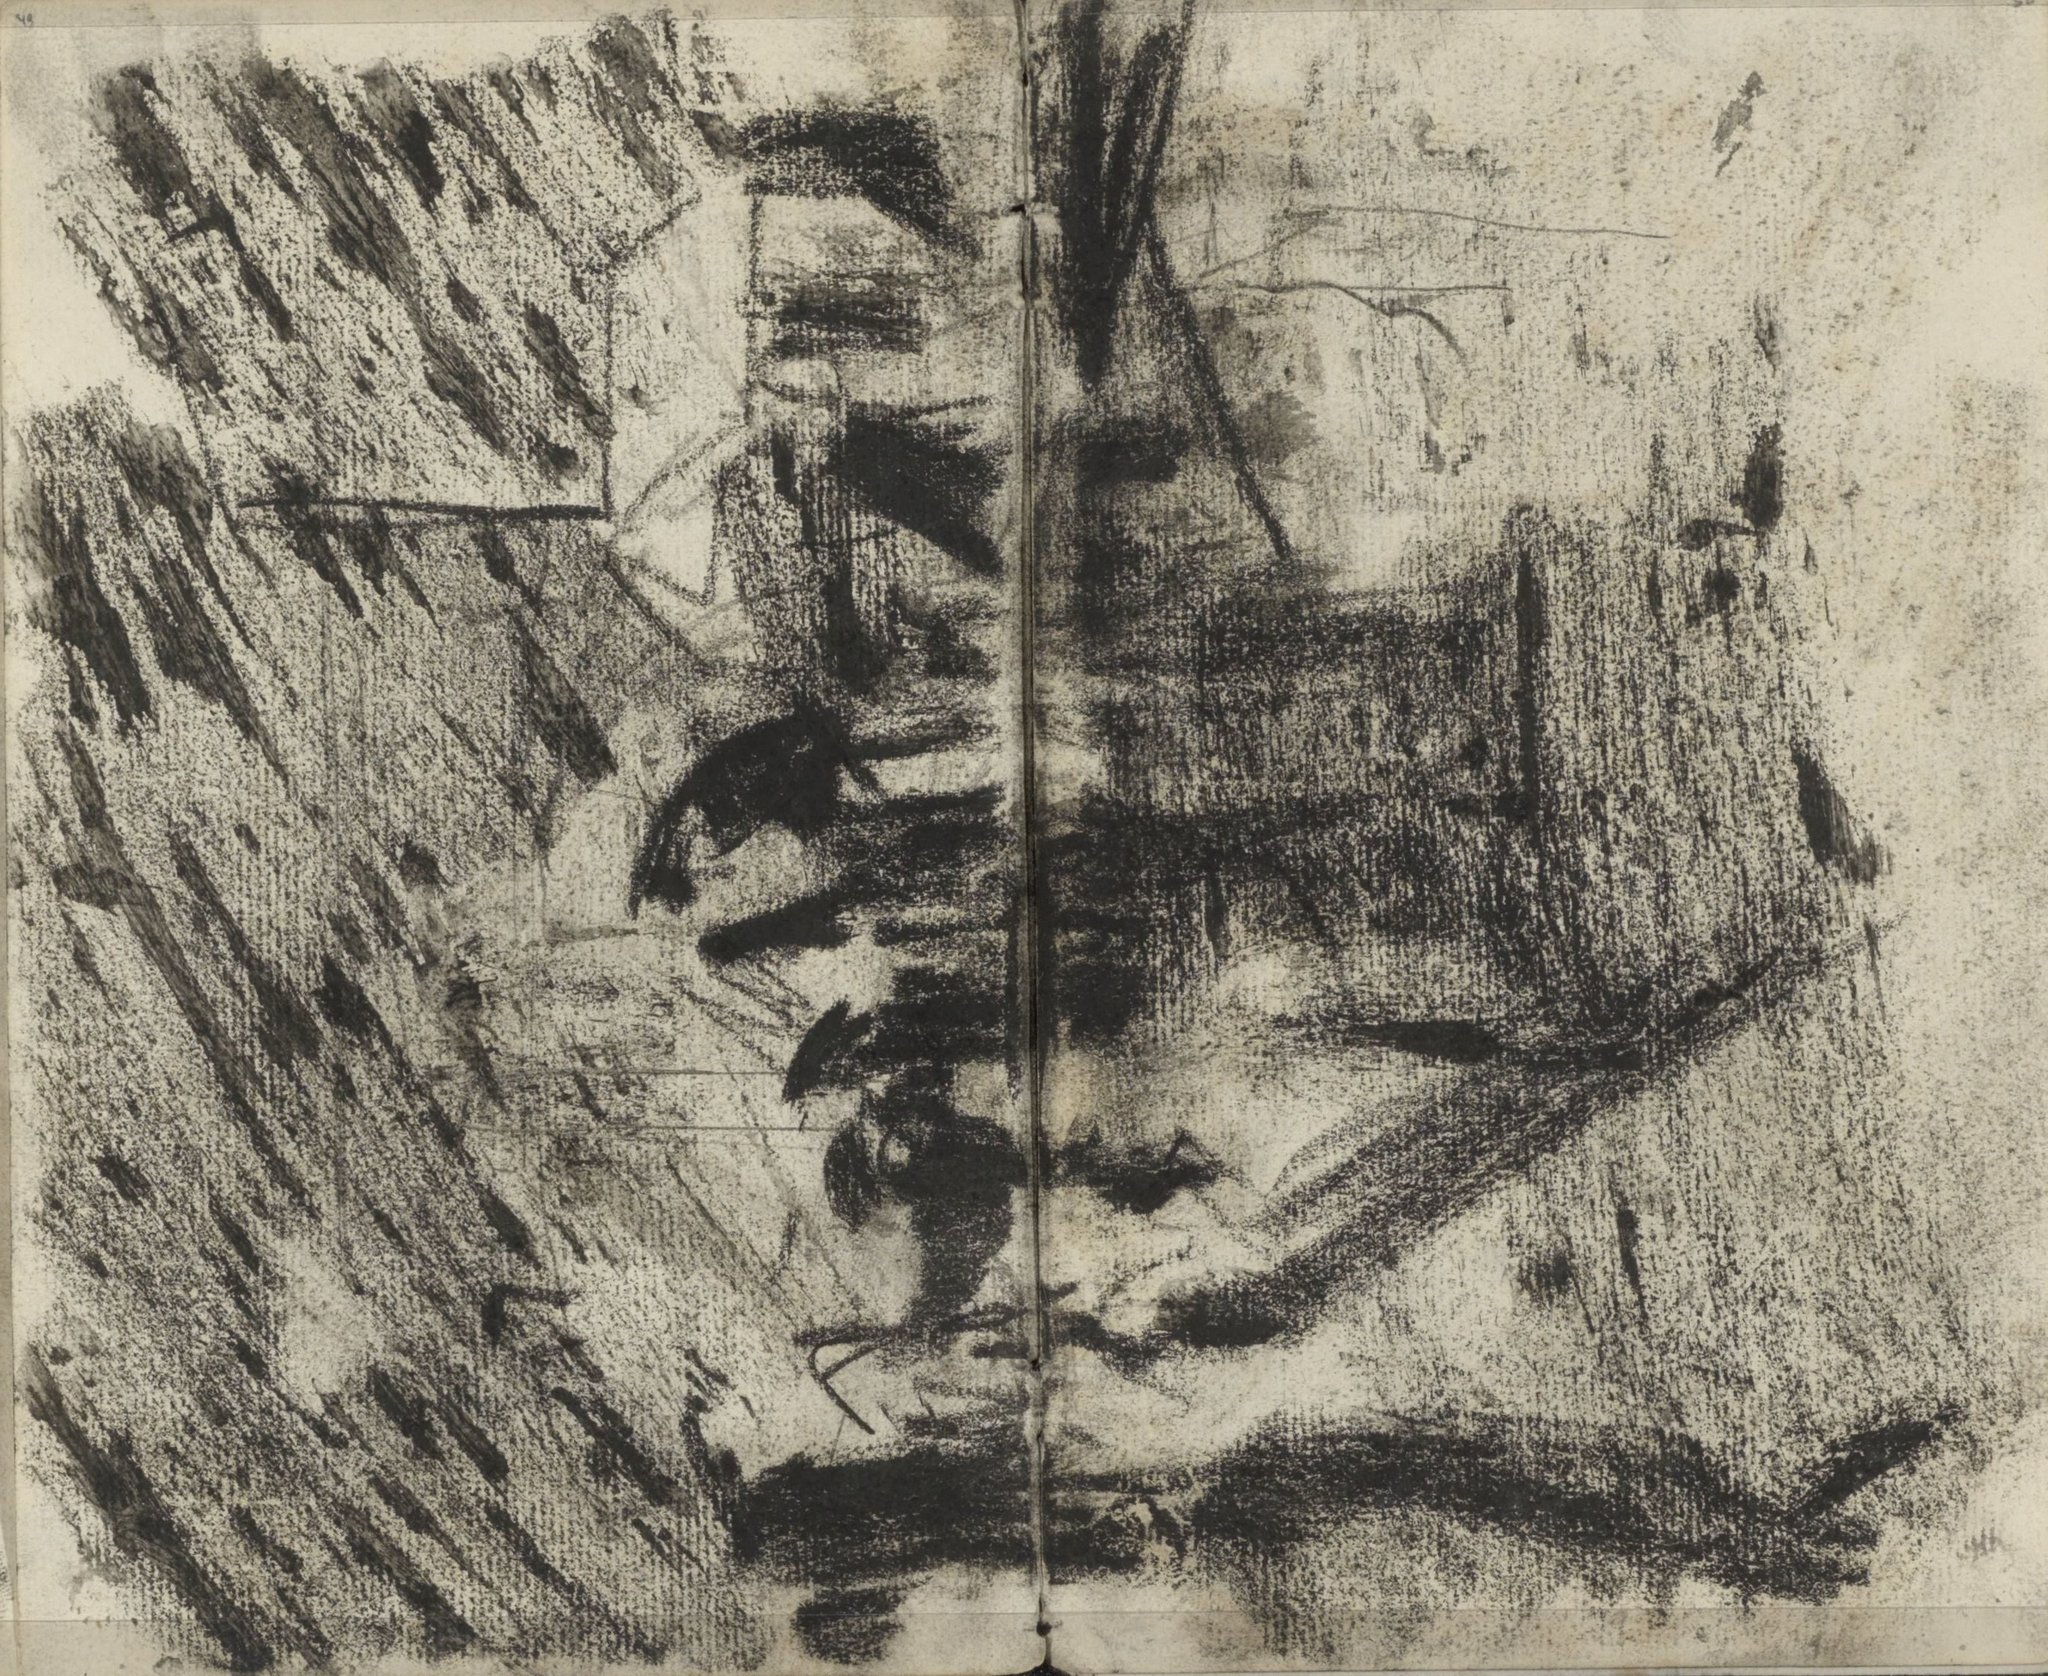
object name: sketchbook leaf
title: Zaterdagavondmarkt aan de Prinsegracht te Den Haag bij regen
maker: george hendrik breitner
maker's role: draughtsman, painter, print maker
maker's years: 1857-1923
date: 1884-1886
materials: chalk, paper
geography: the hague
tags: rain, market, canals, waters (in city) (+ city(-scape) with figures, staffage)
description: Studie voor de aquarel 'Zaterdagavondmarkt bij regen op de Prinsengracht [sic] te Den Haag' (zie Hefting).